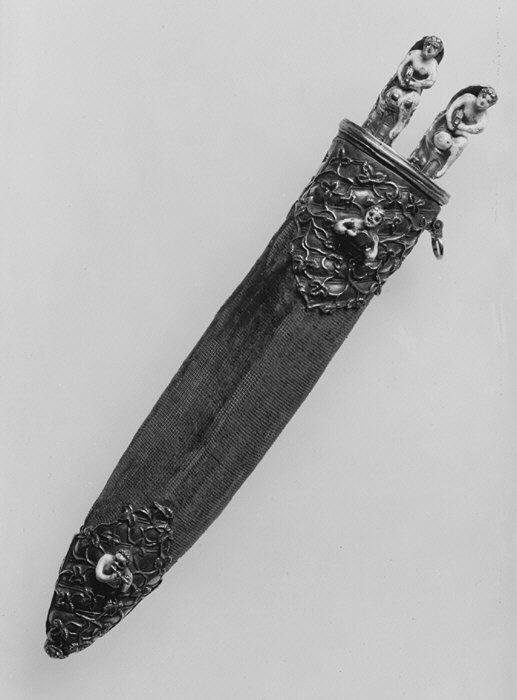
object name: wedding knife and fork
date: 1701-1800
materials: enamel, gold, steel, velvet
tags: men,women,flutes